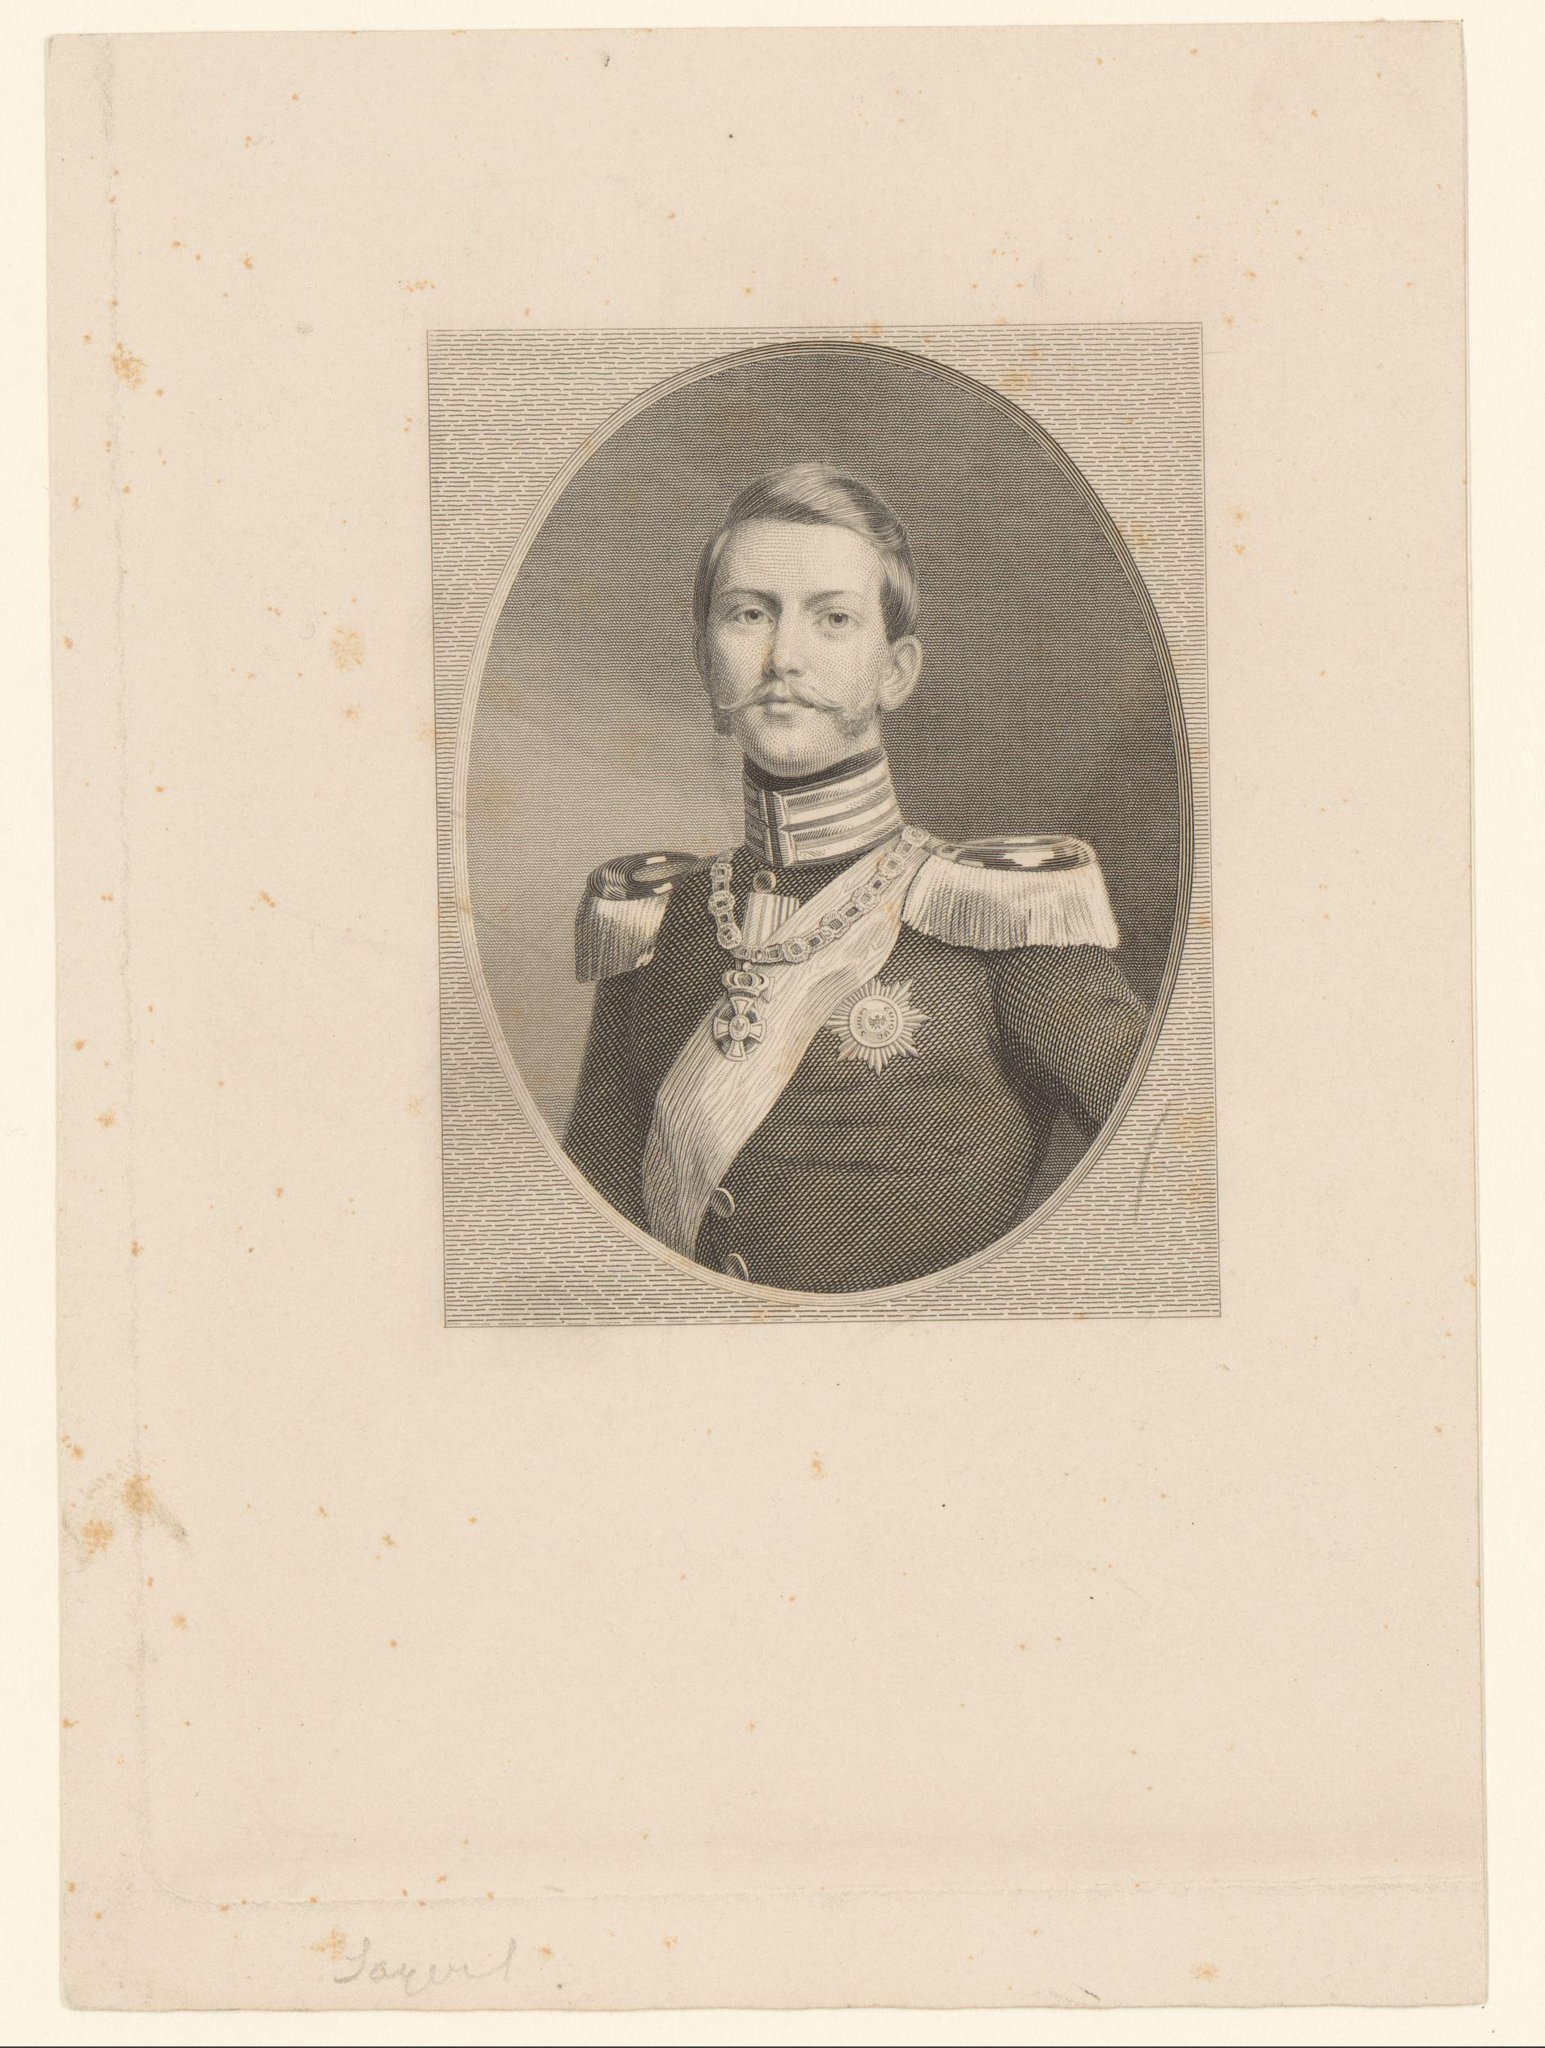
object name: print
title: Portret van Frederik III van Pruisen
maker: hermann sagert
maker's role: print maker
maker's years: 1822-1889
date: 1841-1889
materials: paper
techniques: engraving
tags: knighthood order (with name) - insignia of a knighthood order, e.g.: badge, chain (with name of order), historical persons, medals and other marks of military honour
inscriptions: name, collector's mark: Lugt 2228